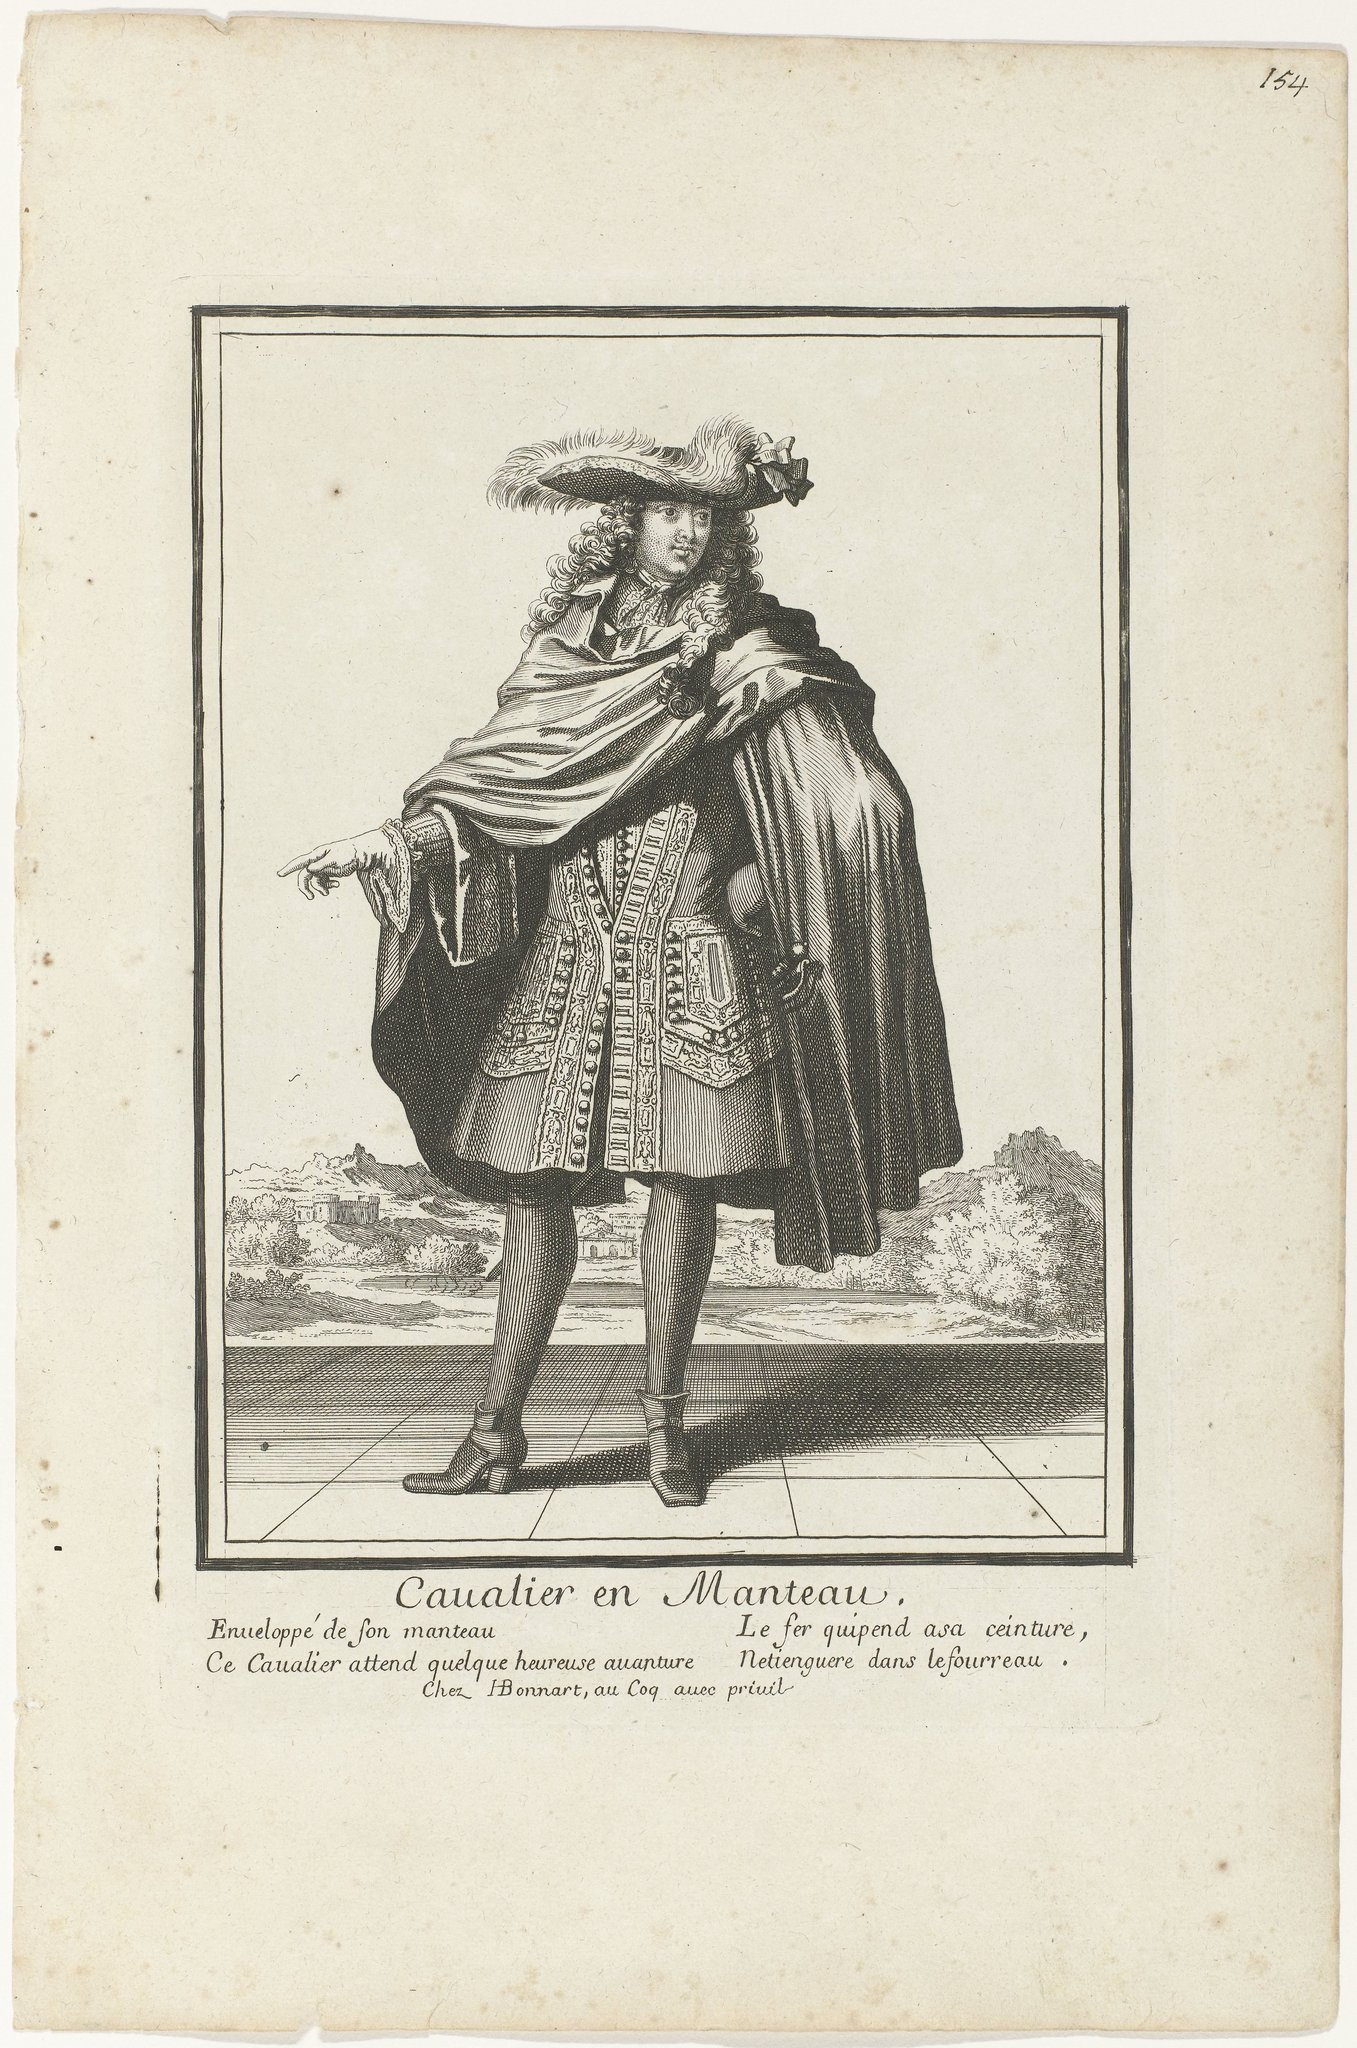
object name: print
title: Cavalier en Manteau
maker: henri bonnart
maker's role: print maker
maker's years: 1642-1711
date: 1687-1690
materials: paper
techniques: engraving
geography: paris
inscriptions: caption: ‘Enveloppé de son manteau / Ce cavalier attend quelque heureuse aventure...’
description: Frans edelman, van voren gezien, gekleed in losse schoudermantel over zijn kostuum. Op zijn lange haren een hoed met brede rand en pluimen.